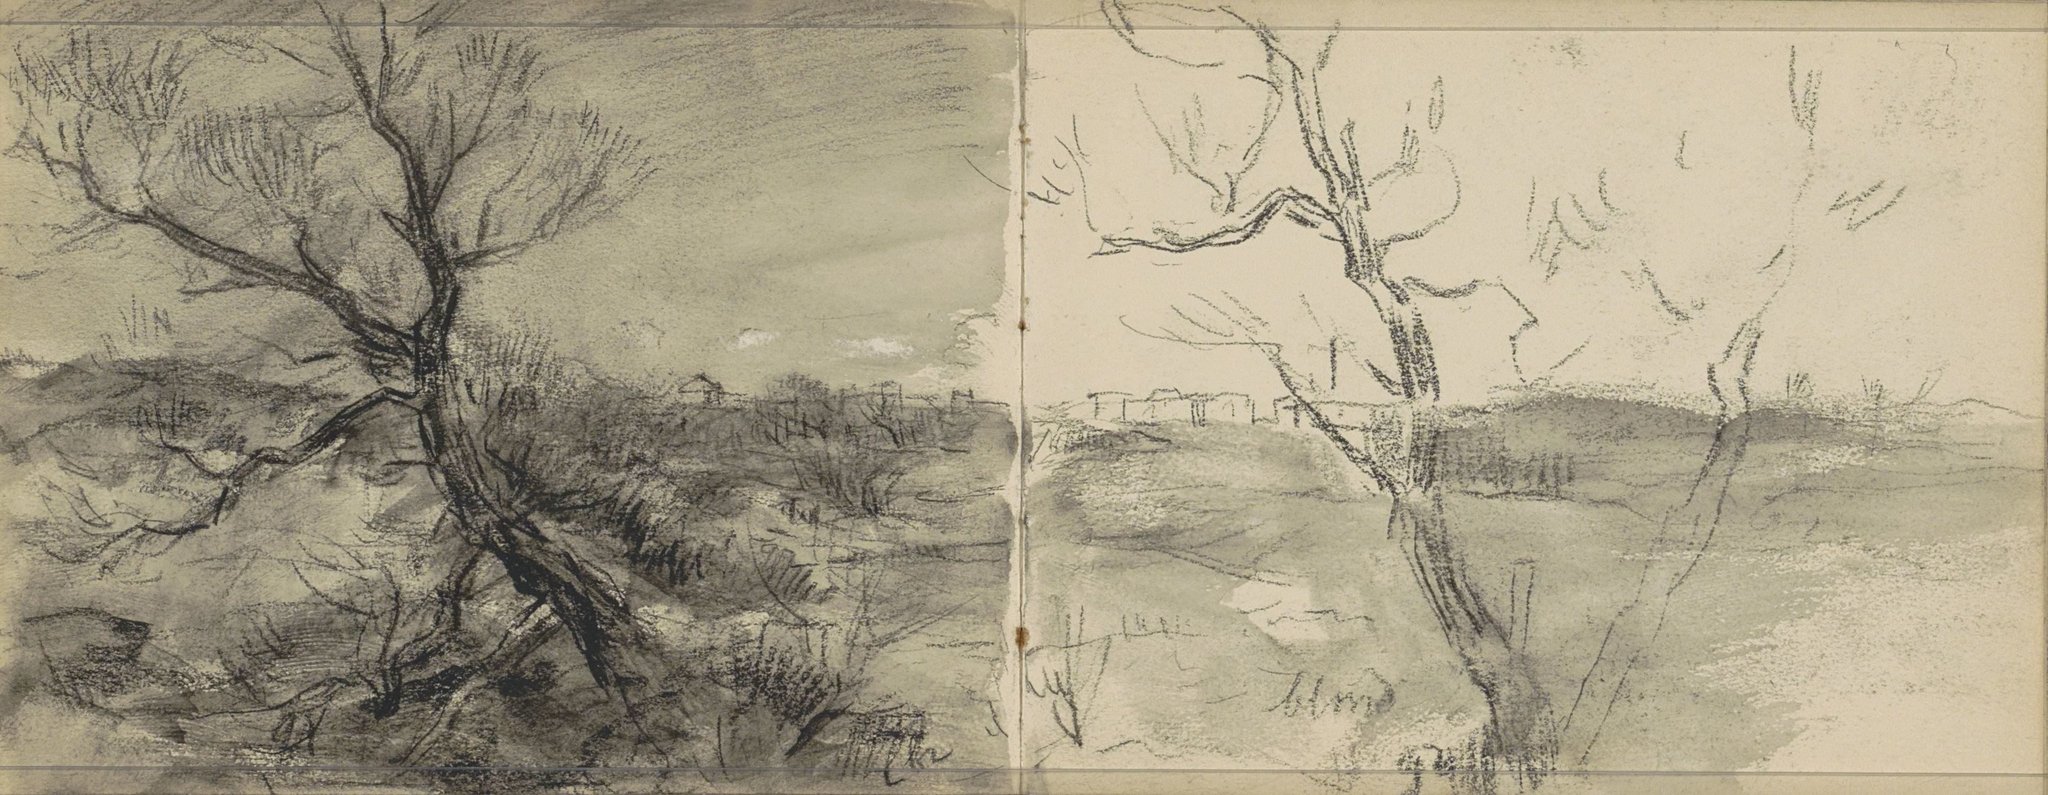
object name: sketchbook leaf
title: Landschap, mogelijk een duinlandschap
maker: johan antonie de jonge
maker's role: draughtsman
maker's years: 1864-1927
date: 1881-1927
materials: chalk, paper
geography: south holland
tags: dunes (sea not visible); in the dunes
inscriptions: kleurnotitie, handgeschreven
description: Landschap, mogelijk een duinlandschap. Blad 13 verso en blad 14 recto uit een schetsboek met 34 bladen.